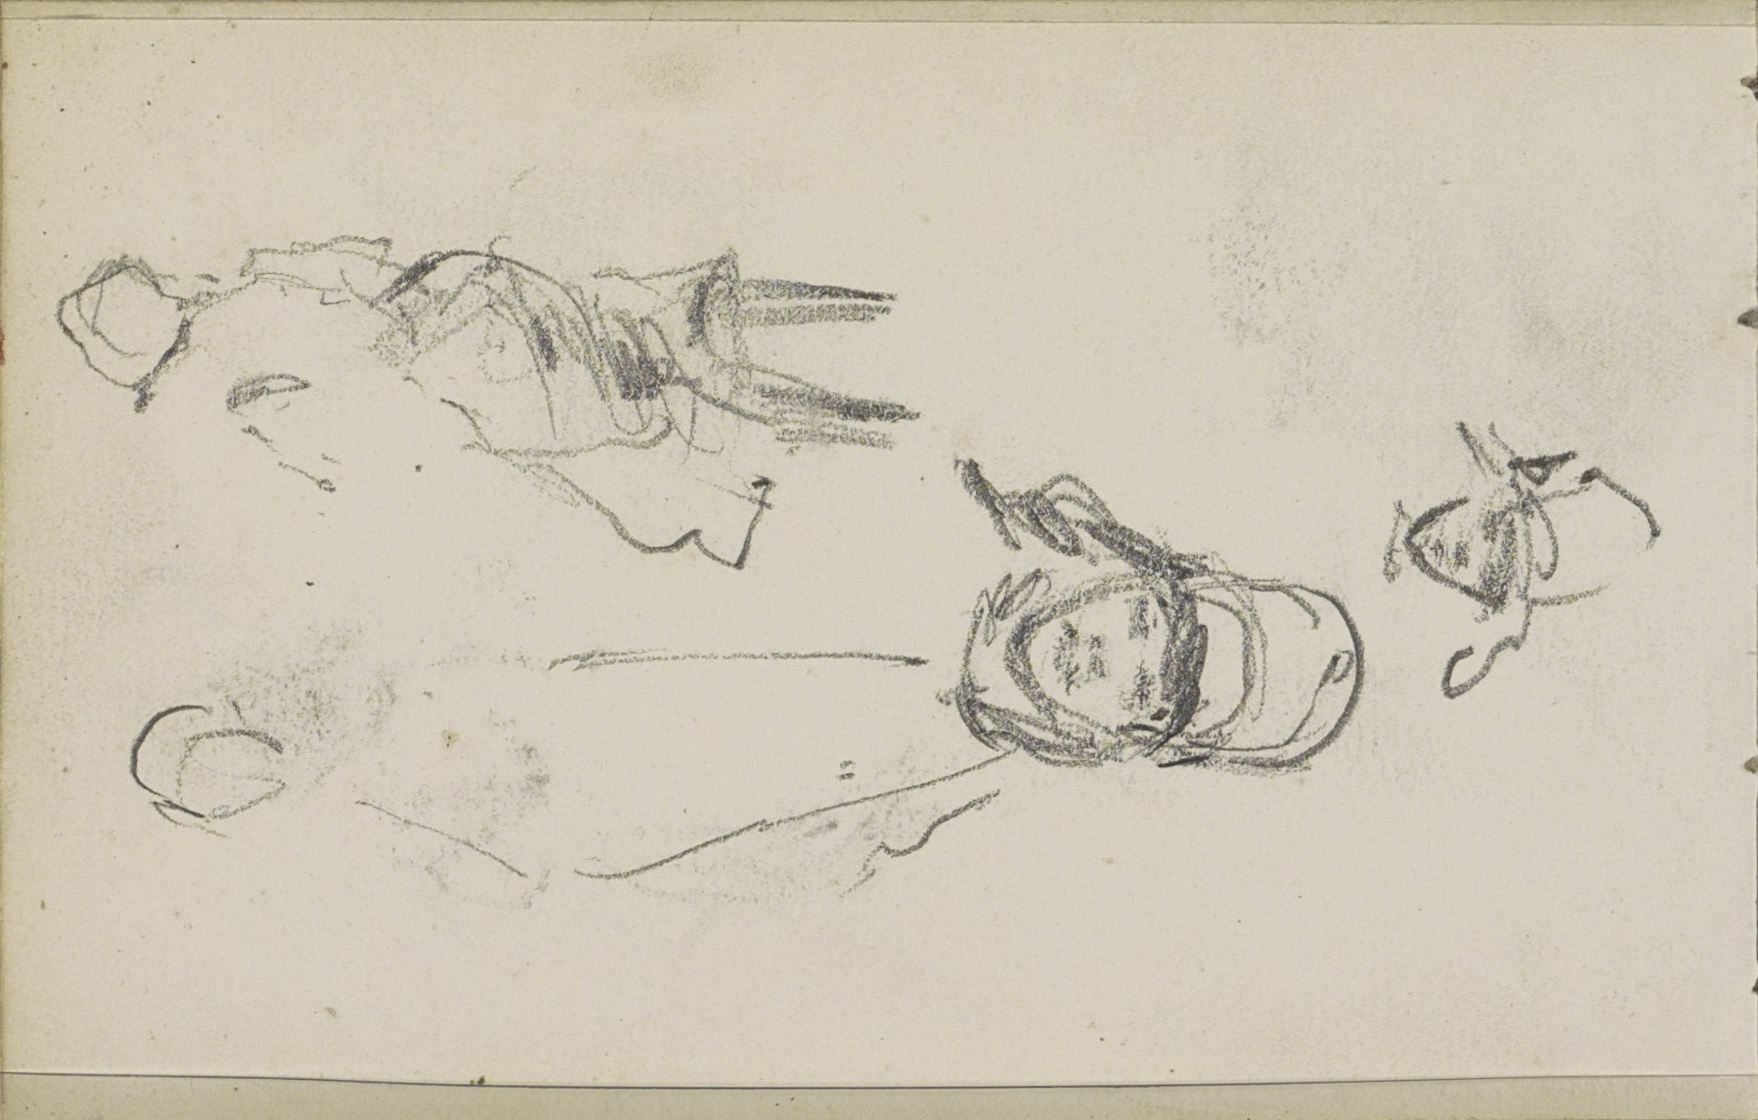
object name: sketchbook leaf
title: Studieblad, onder andere met koppen met traditionele mutsen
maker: george clausen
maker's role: draughtsman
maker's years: 1852-1912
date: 1875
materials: paper, pencil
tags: head-gear: cap (+ women's clothes), folk costume, regional costume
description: Blad 25 verso uit een schetsboek met 38 bladen.